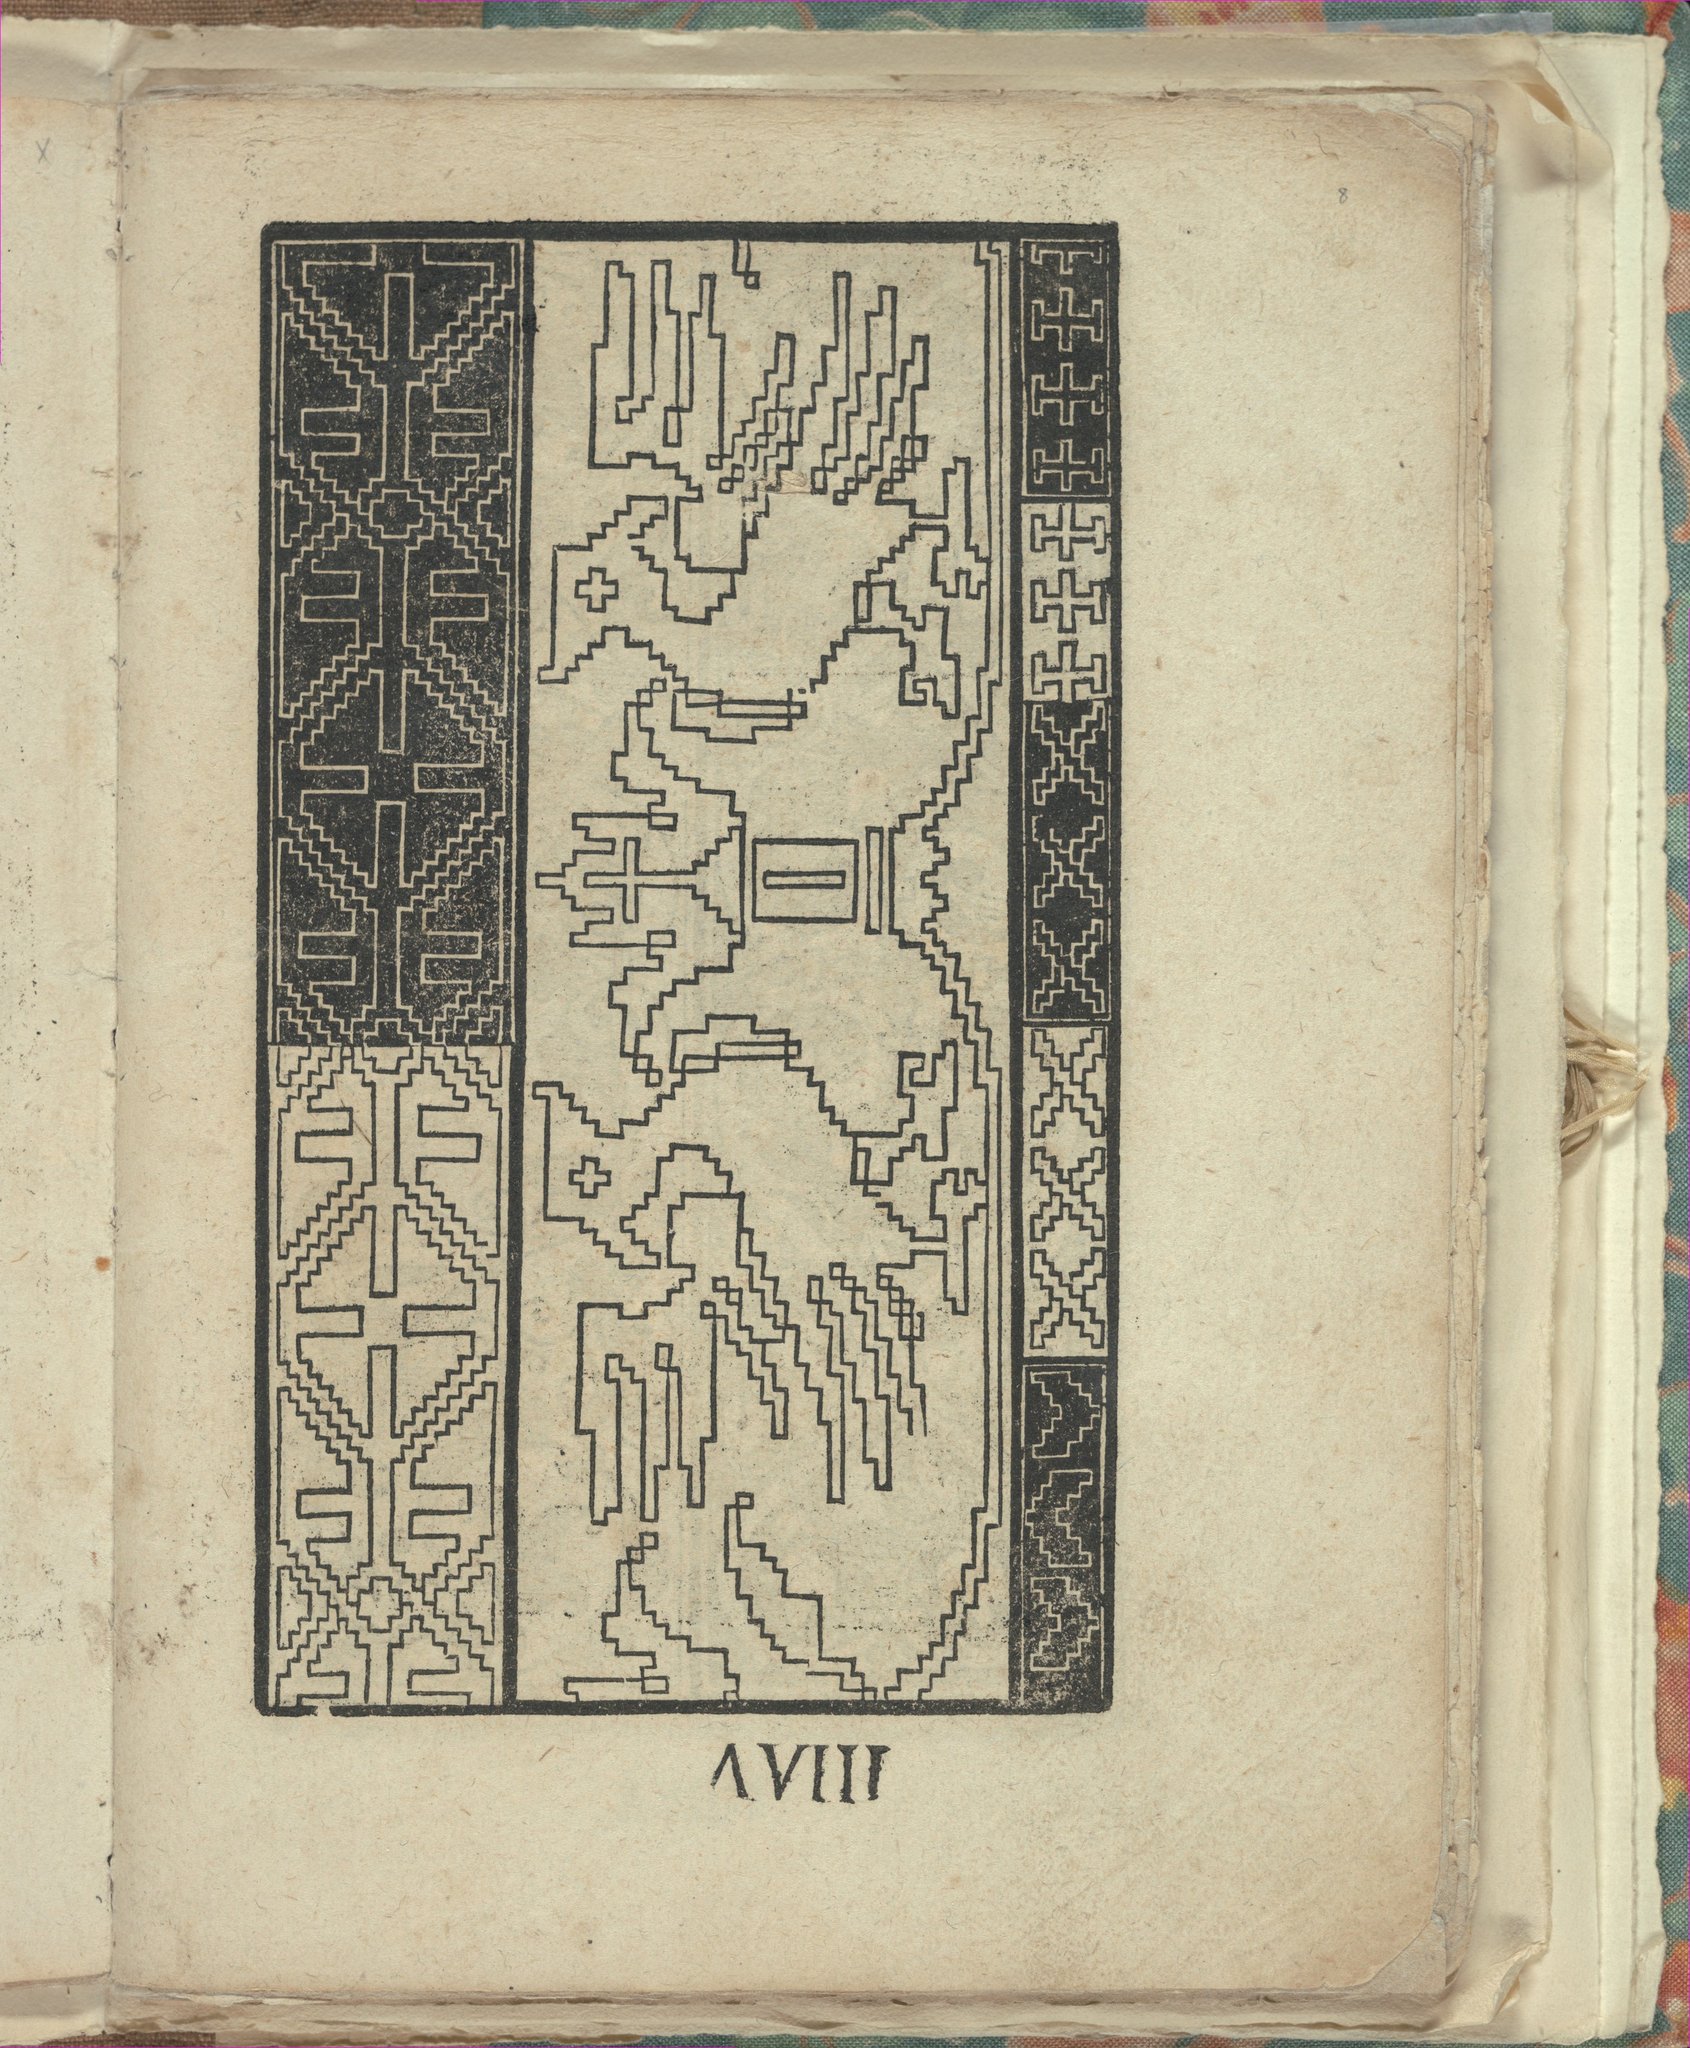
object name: book print ornament architecture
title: Opera Nova Universali intitulata Corona di racammi, page 8 (recto)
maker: giovanni andrea vavassore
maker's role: publisher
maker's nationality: italian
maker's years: 1530-1573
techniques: woodcut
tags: birds,ornament